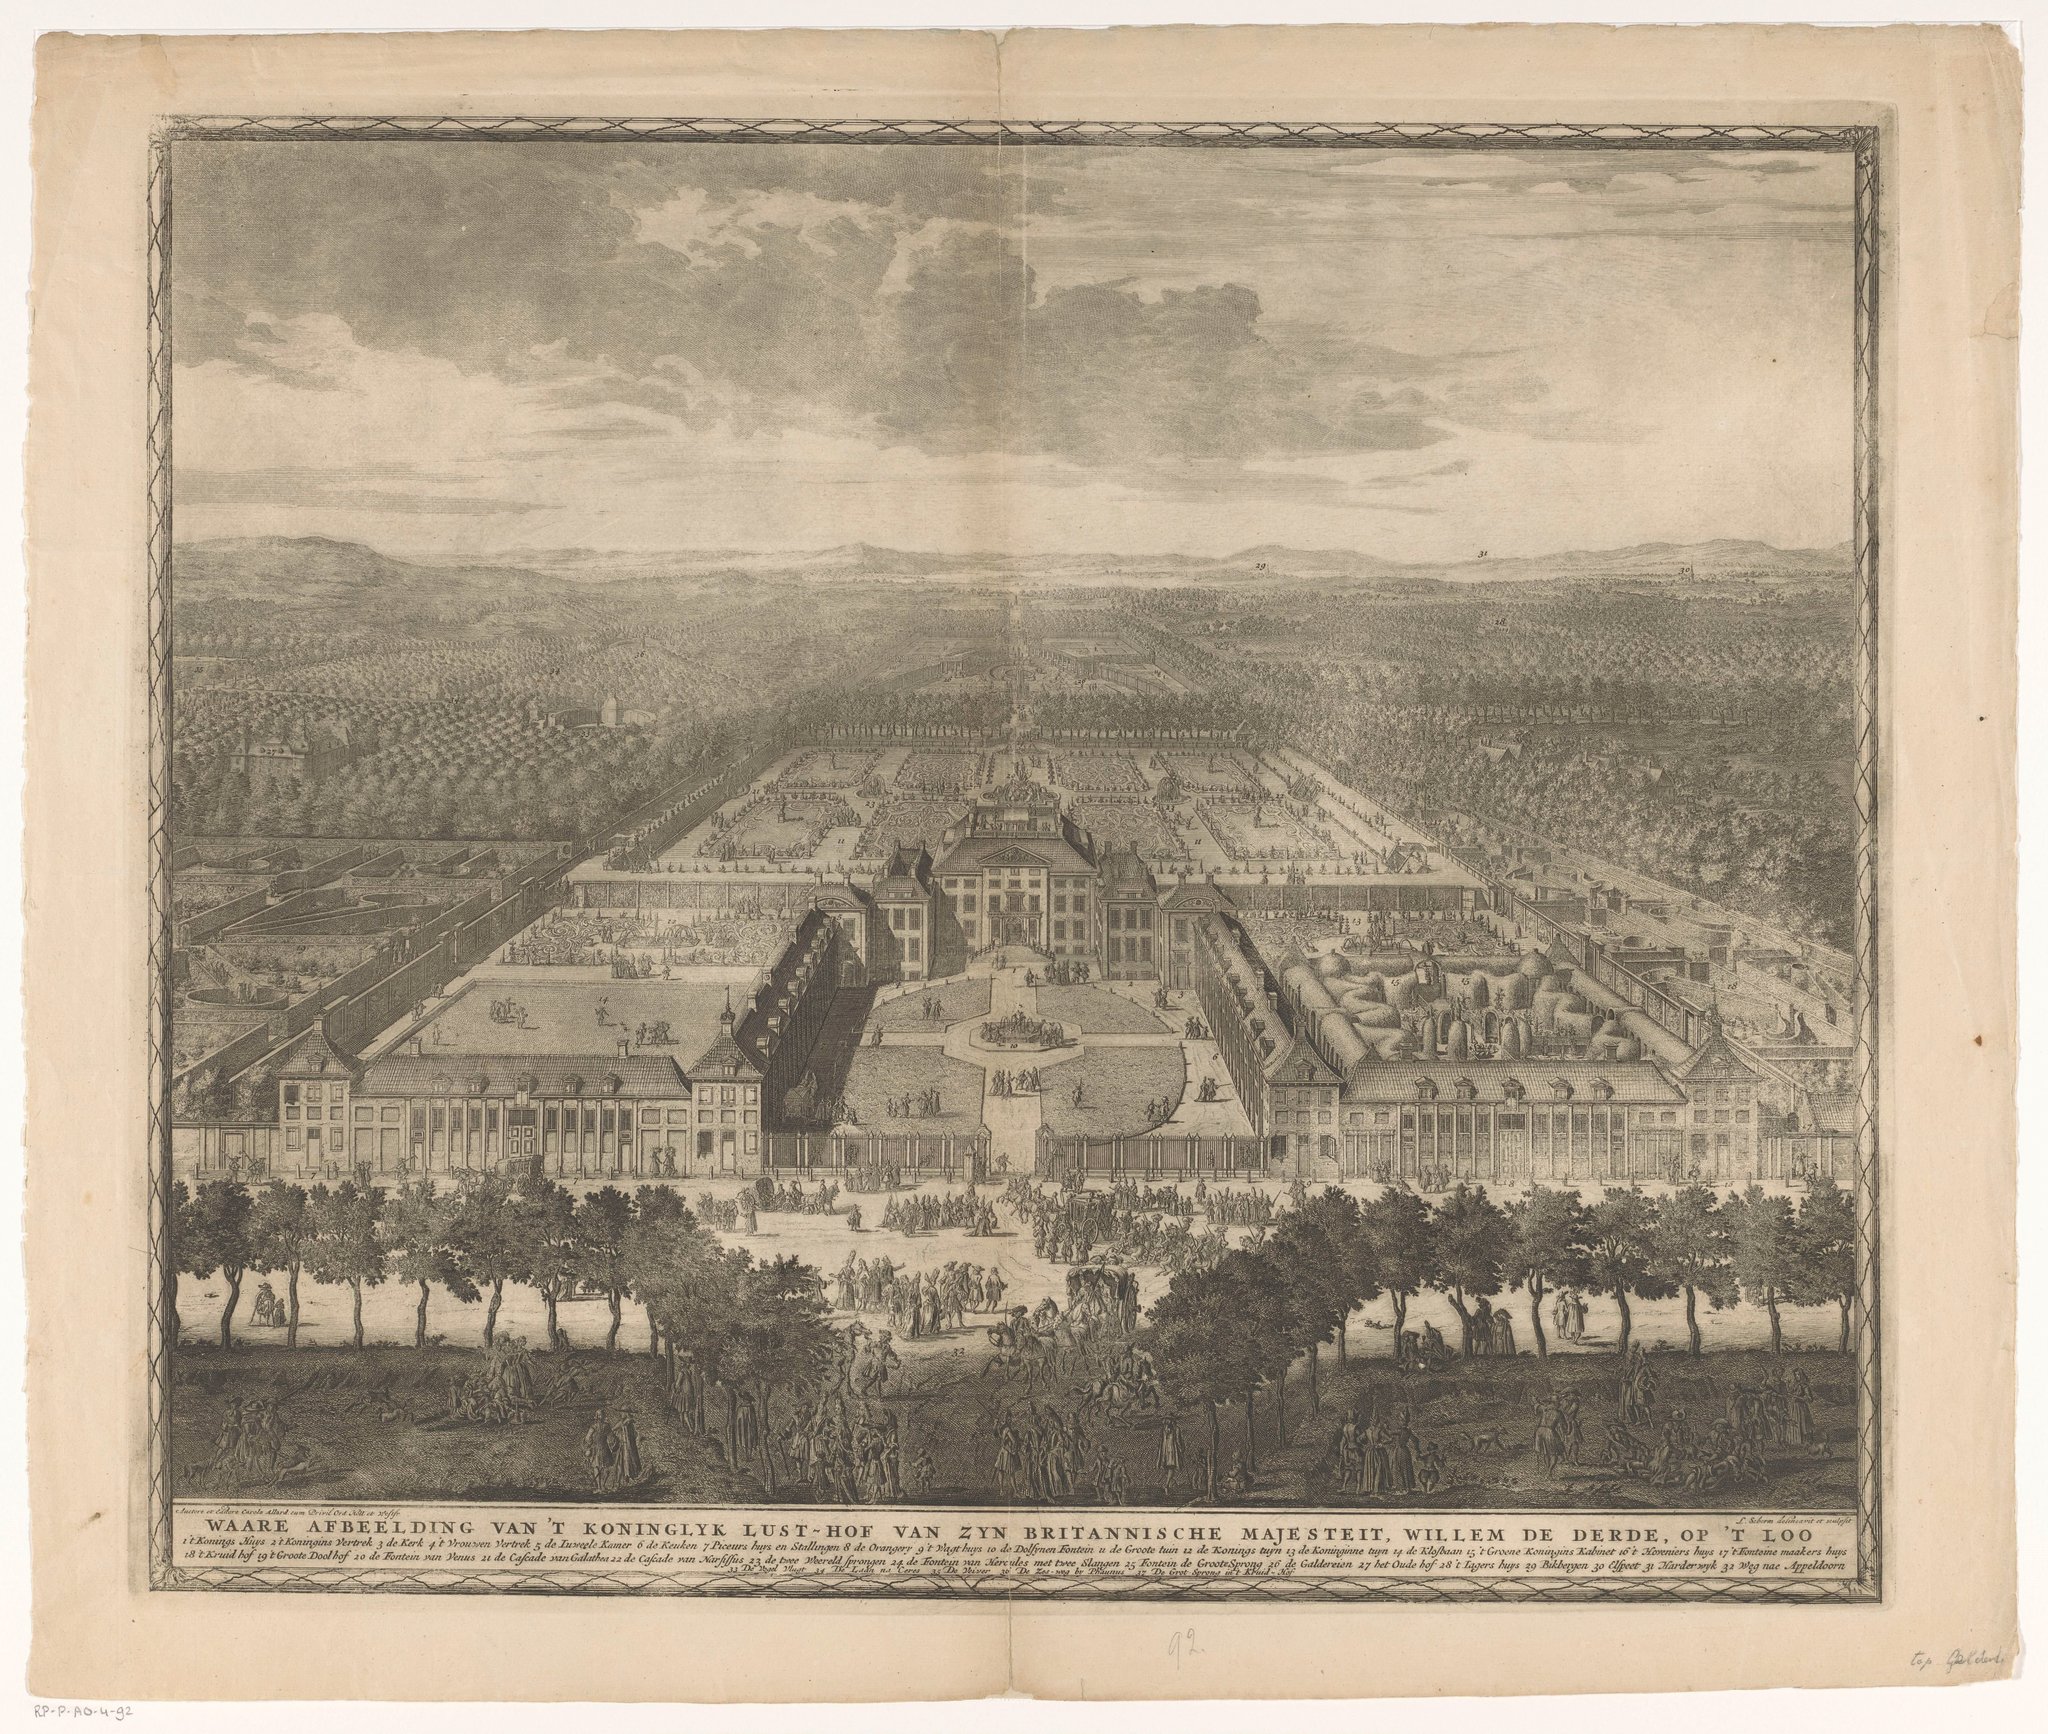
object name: print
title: Waare afbeelding van 't koninglyk lust-hof van zyn Brittannische majesteit, Willem de derde, op 't Loo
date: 1689-1702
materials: paper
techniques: engraving, etching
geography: amsterdam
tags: william iii (prince of orange and king of england, scotland, and ireland), palace, french or architectonic garden; formal garden, bird's eye view ~ representation of building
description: Gezicht op Paleis Het Loo te Apeldoorn in vogelvluchtperspectief, in de tijd dat het in bezit van stadhouder-koning Willem III was. Rondom en achter het paleis de tuinen. Links het Oude Loo. Onderaan in de marge de titel en de legenda.